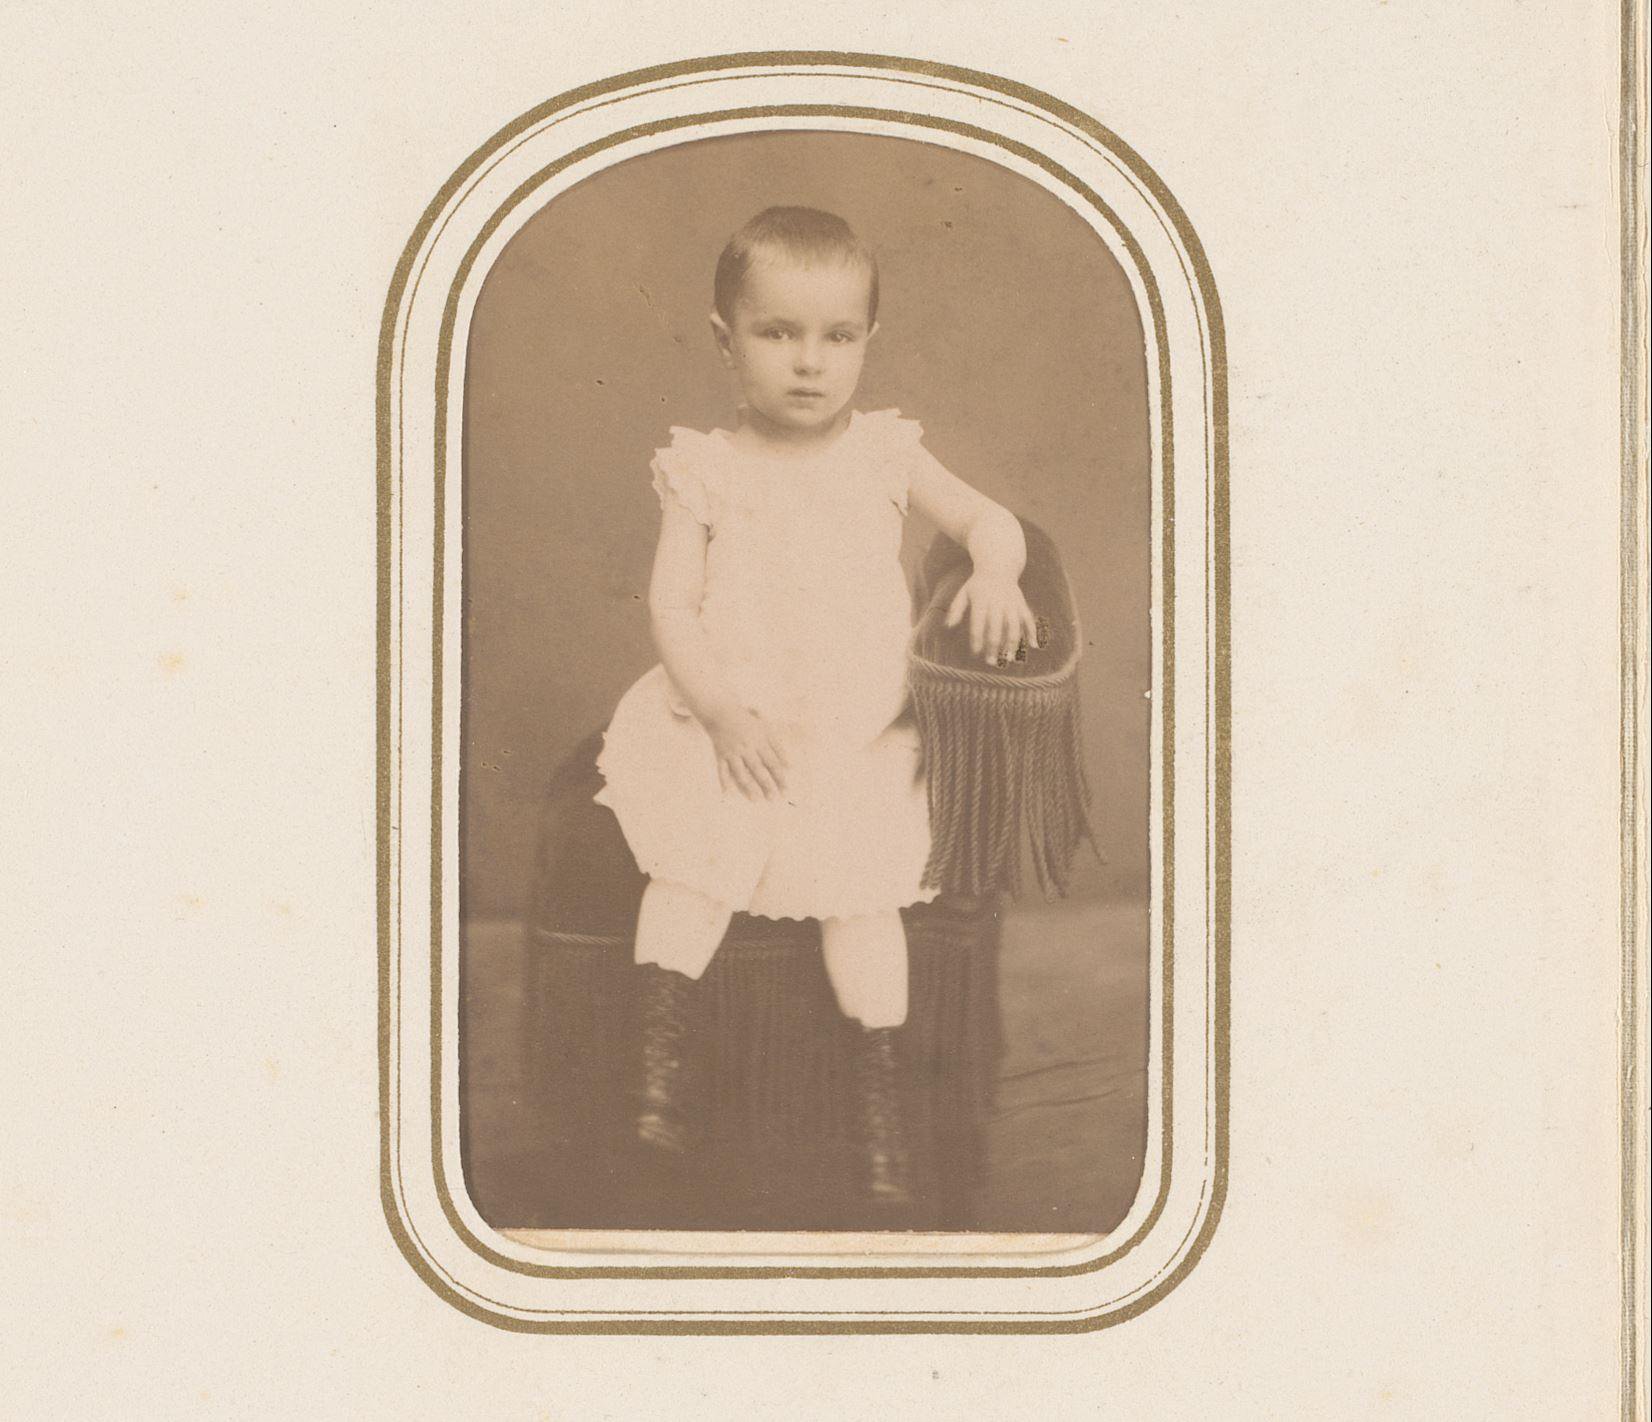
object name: album leaf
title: Portret van een kind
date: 1865-1895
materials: cardboard, photographic support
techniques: albumen print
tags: child, historical persons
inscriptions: inscription: ‘Numa Fils/ Photographe/ 47, rue Vincent/ Paris’